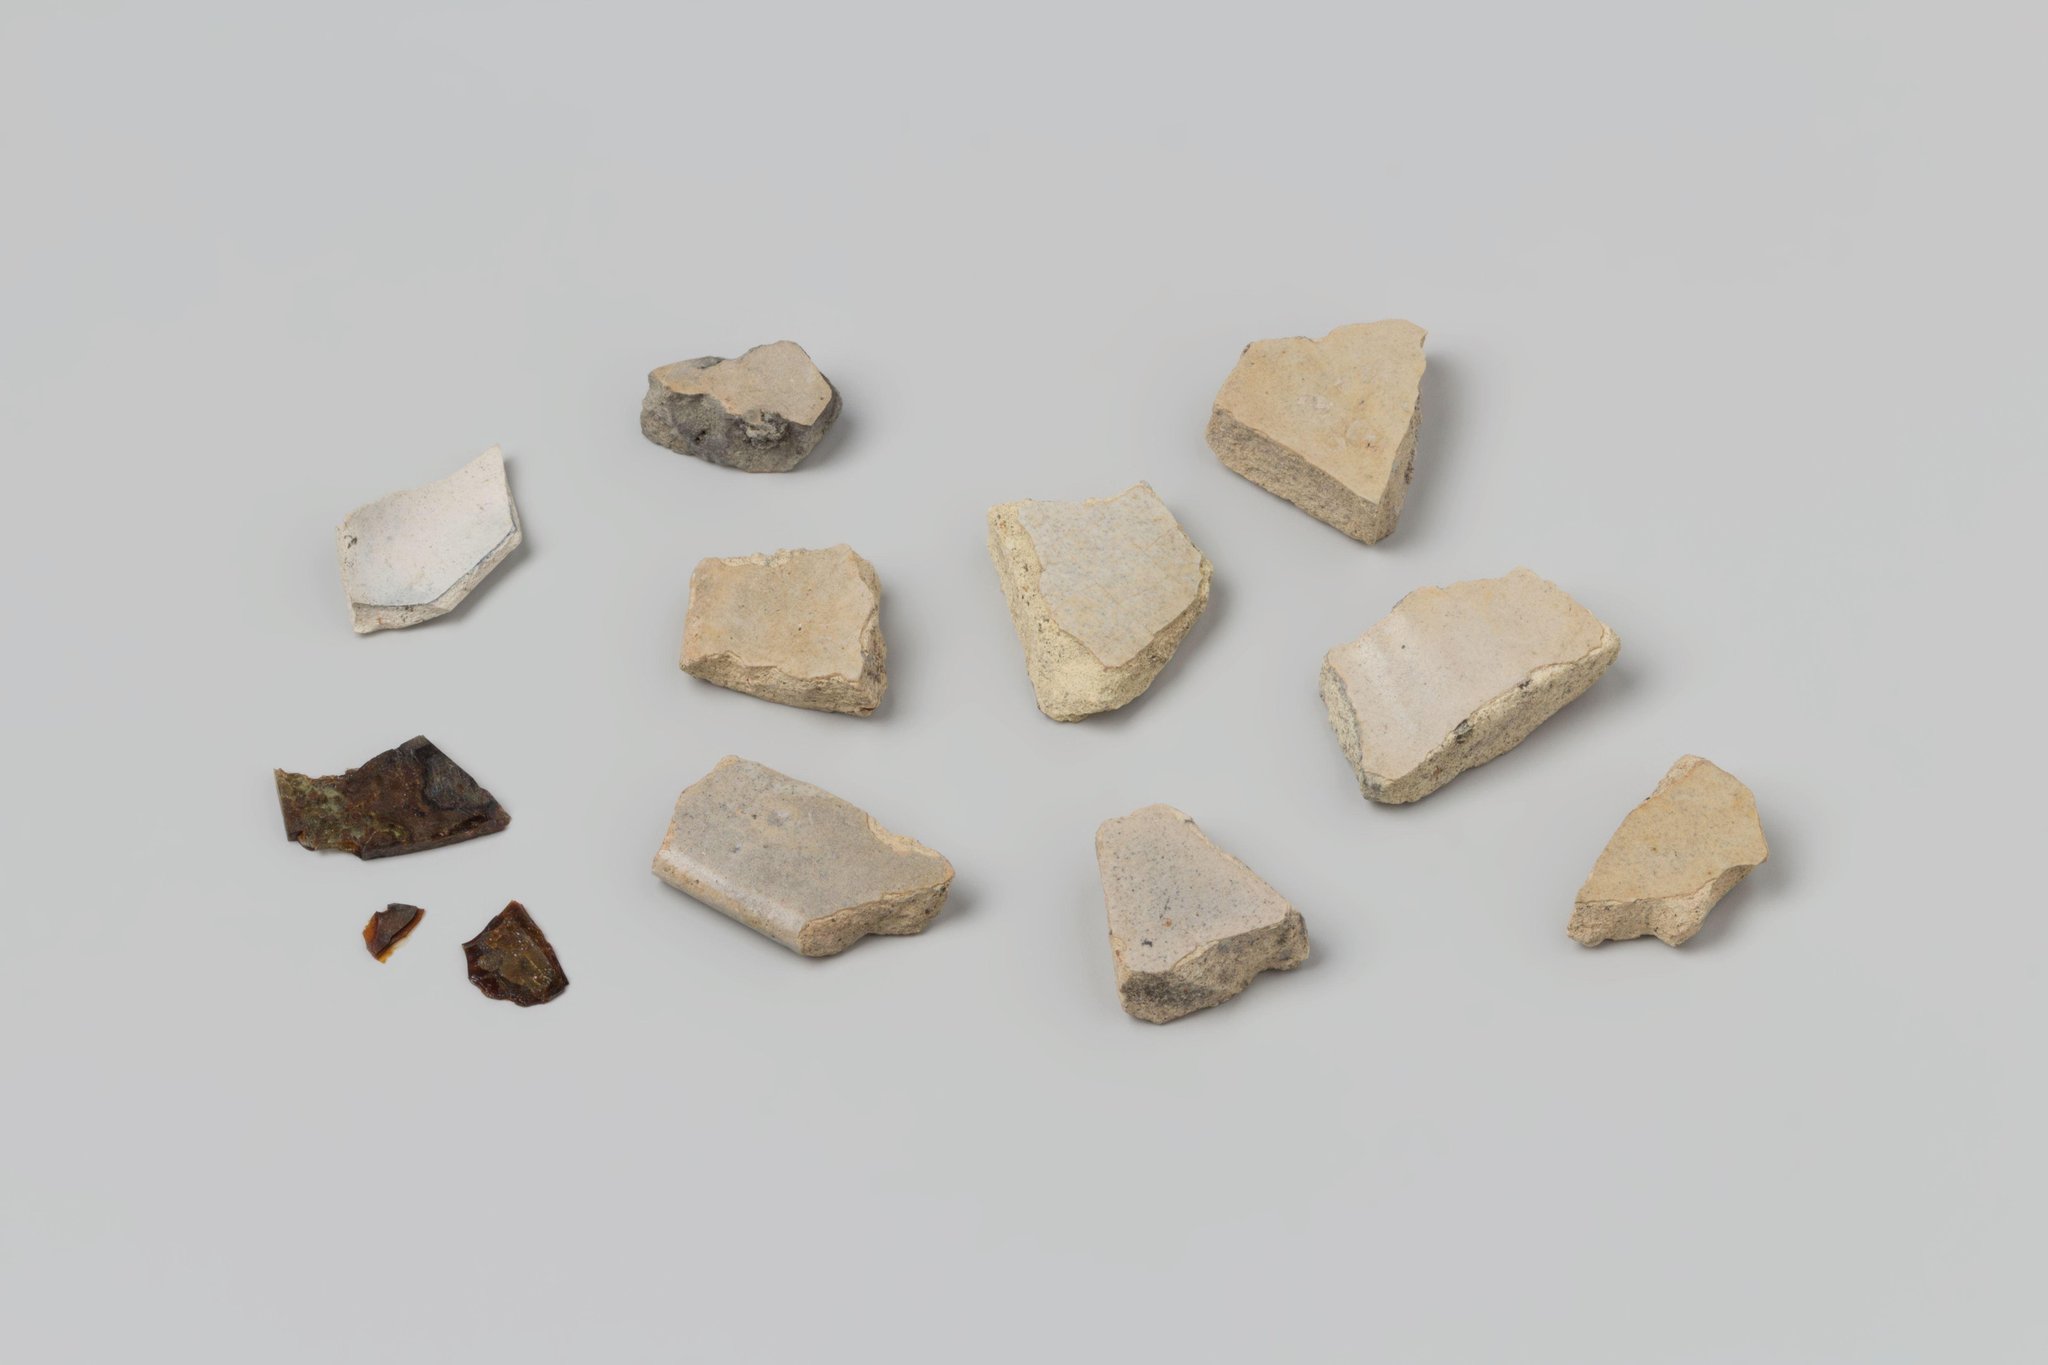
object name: apothecary jar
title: Scherven van een apothekerspot en glas uit het wrak van de Oost-Indiëvaarder 't Vliegend Hart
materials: earthenware, glass, glaze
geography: netherlands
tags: 't vliegend hart (schip), verenigde oostindische compagnie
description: Zeven scherven van geelbakkend aardewerk met beigegrijs glazuur die deel uit maakten van een apothekerspot. Twee scherven van glas en een grijsbakkende en witbakkende aardewerkscherf.